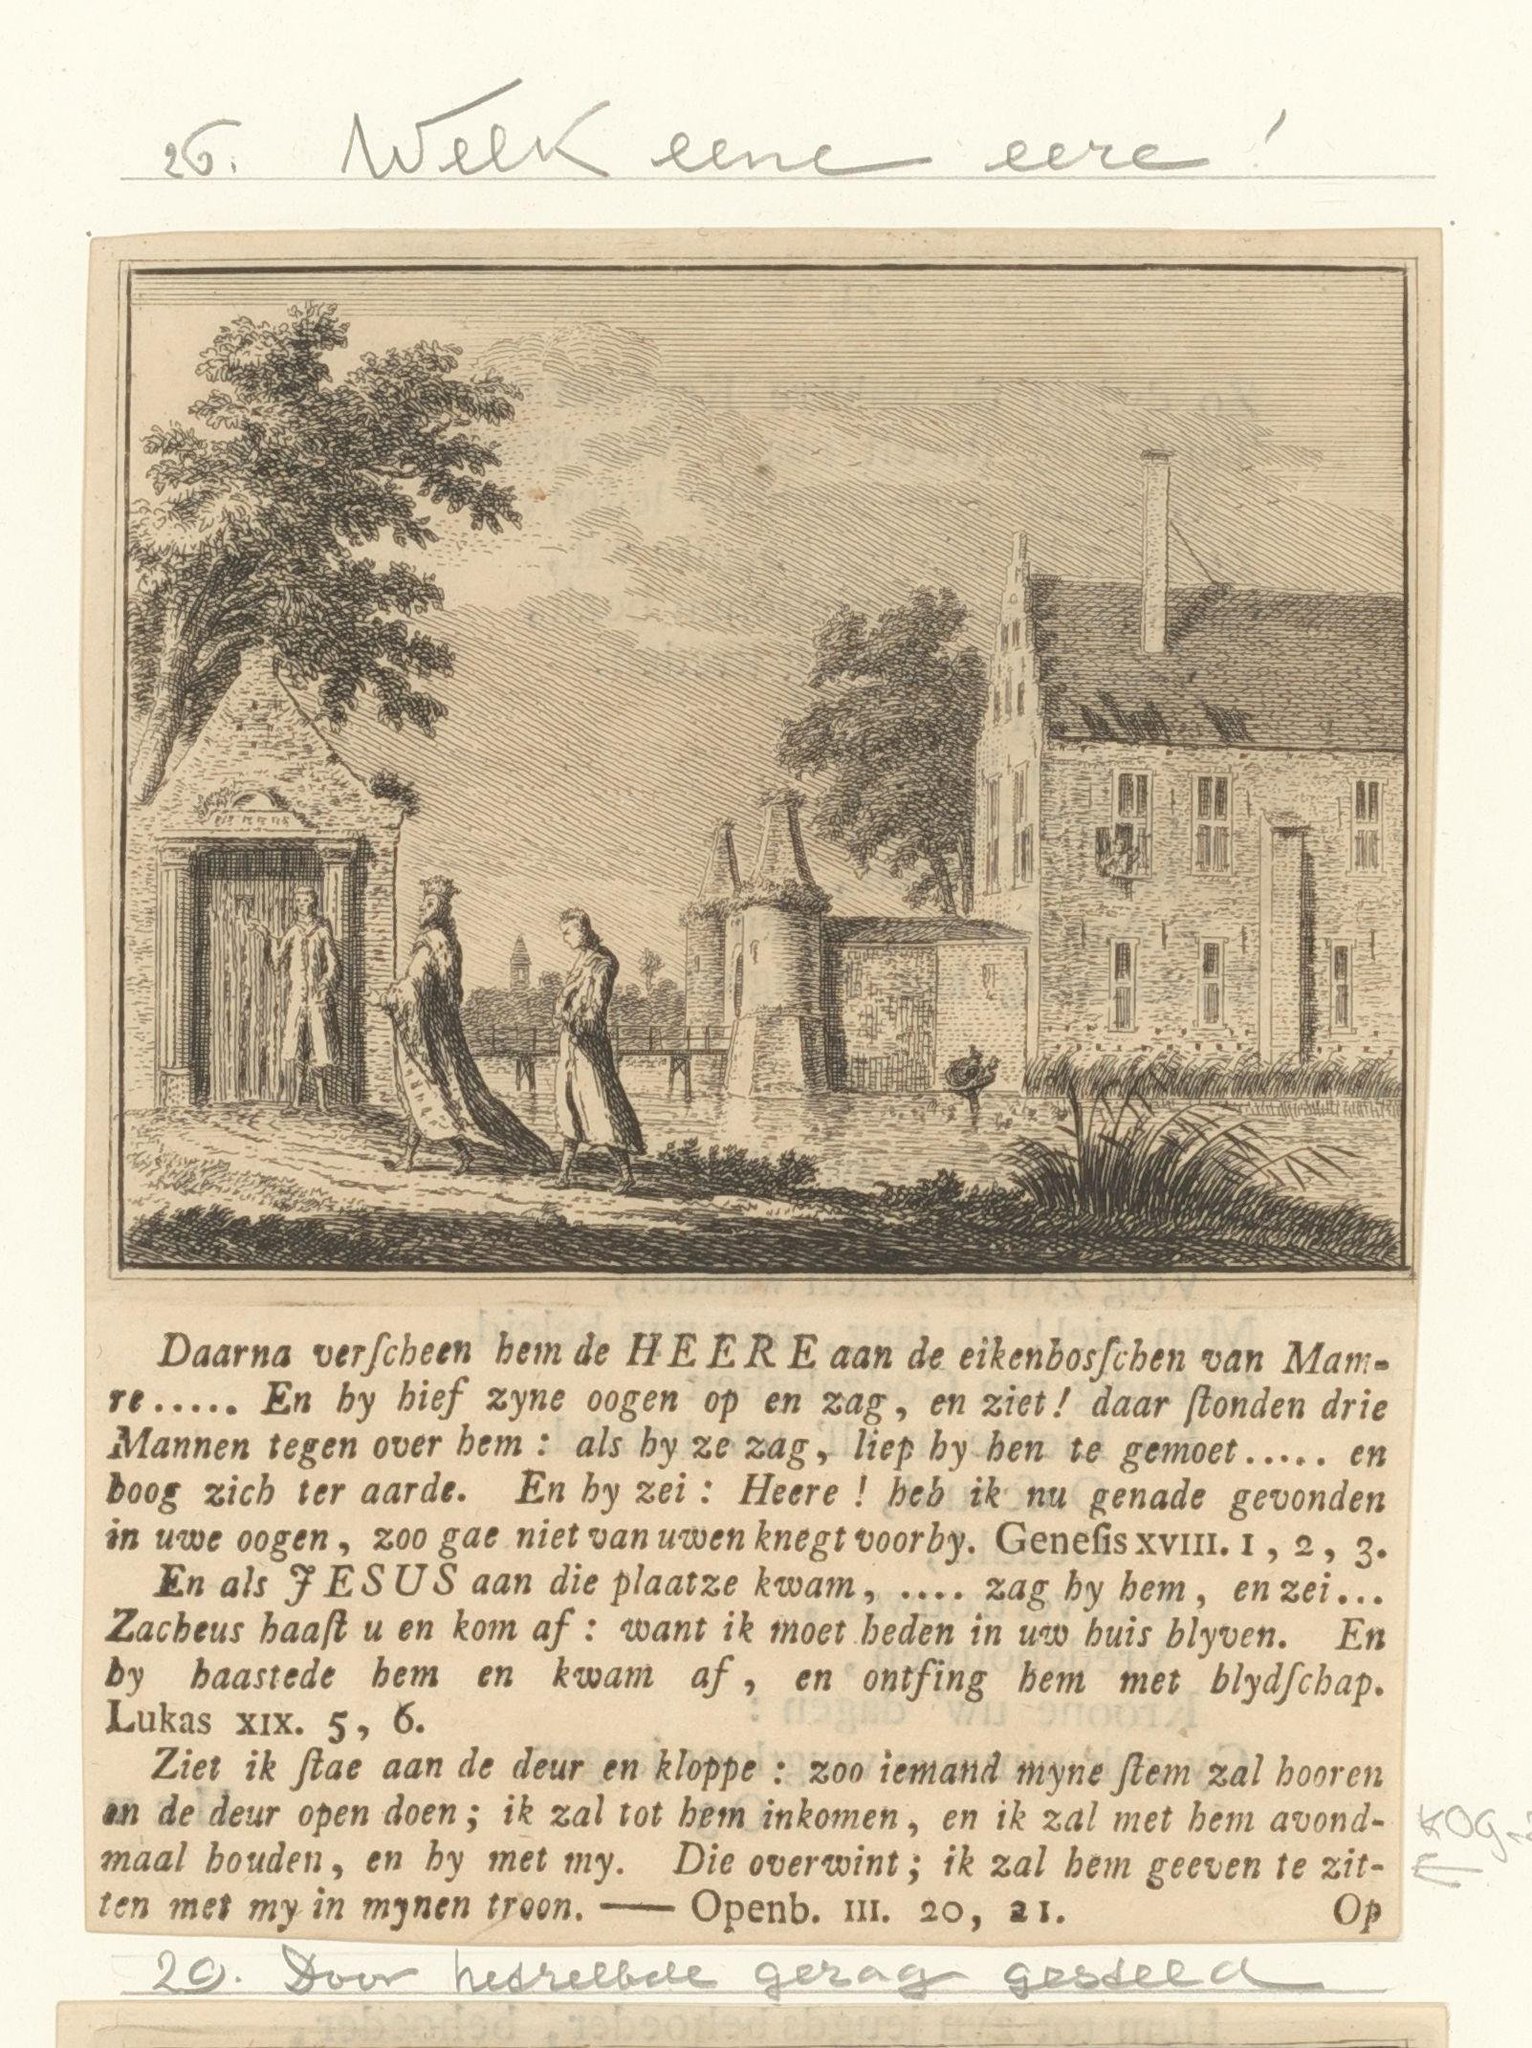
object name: print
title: Koning loopt richting een kasteel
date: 1758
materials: paper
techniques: etching, letterpress printing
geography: haarlem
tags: castle, proverbs, sayings, etc., king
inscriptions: collector's mark: Lugt 1641, stamp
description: Embleem bij het motto: Welke eene Eere. Onderaan een dertienregelige tekst in het Nederlands. Onderwerpsrubrieken binnen de Atlas Zeden en Gewoonten: Zeden en Gewoonten in engeren zin. Volksleven. Zinnebeeldige voorstellingen uit het volkleven op serieprenten. Maanden en diversen (allegorieën).